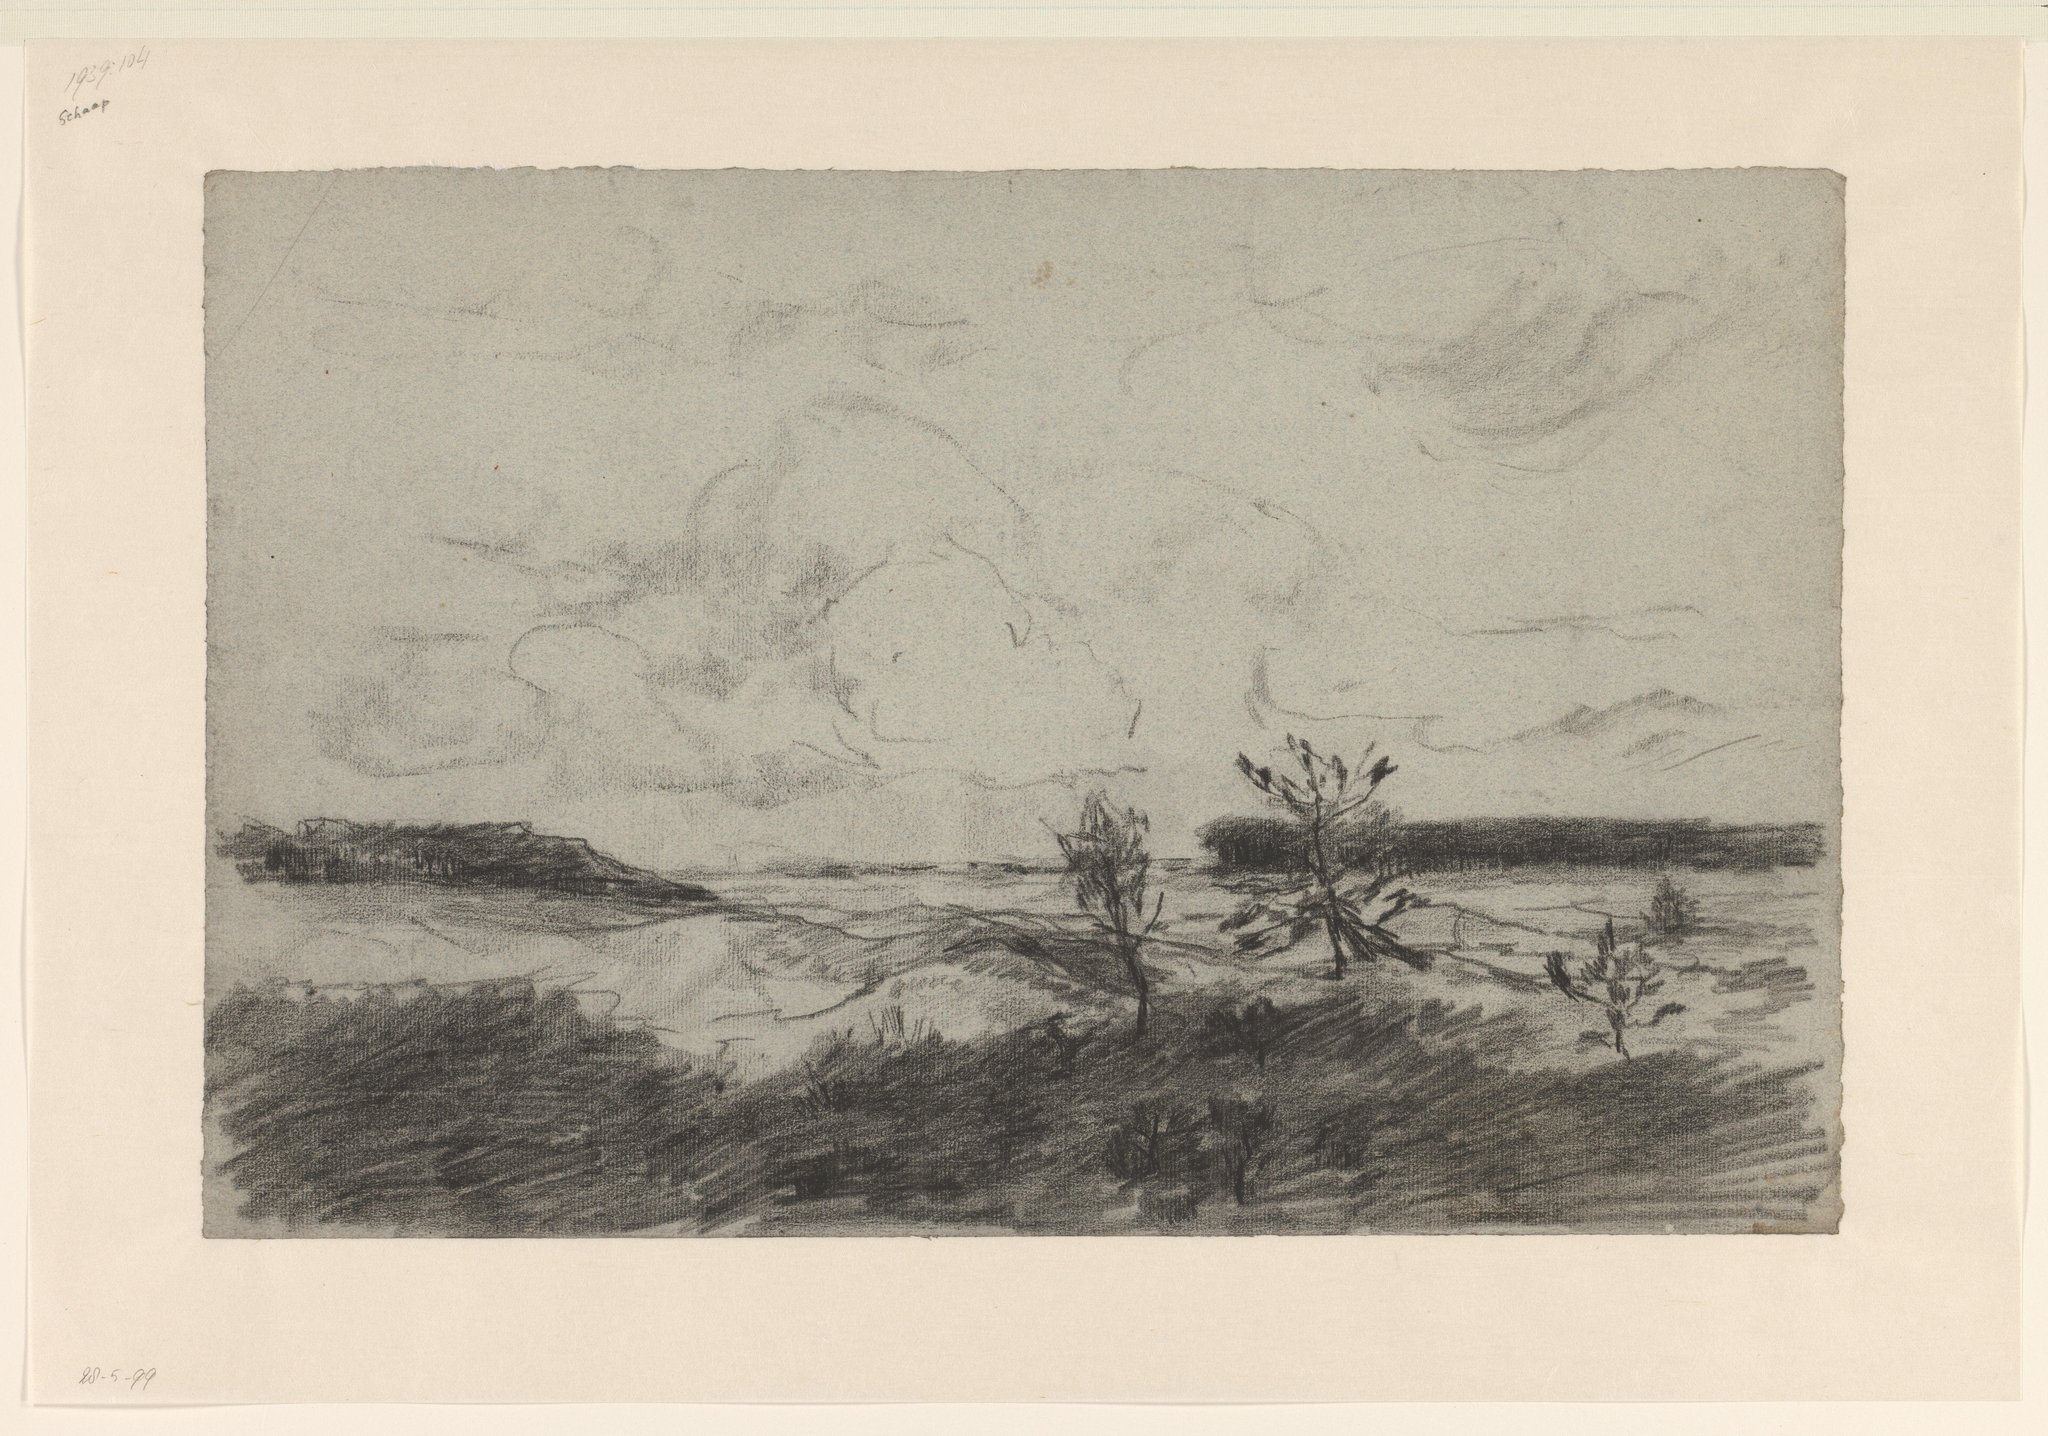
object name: drawing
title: Vlak landschap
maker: egbert rubertus derk schaap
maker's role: draughtsman, painter, print maker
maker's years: 1862-1939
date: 1872-1939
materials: chalk, paper